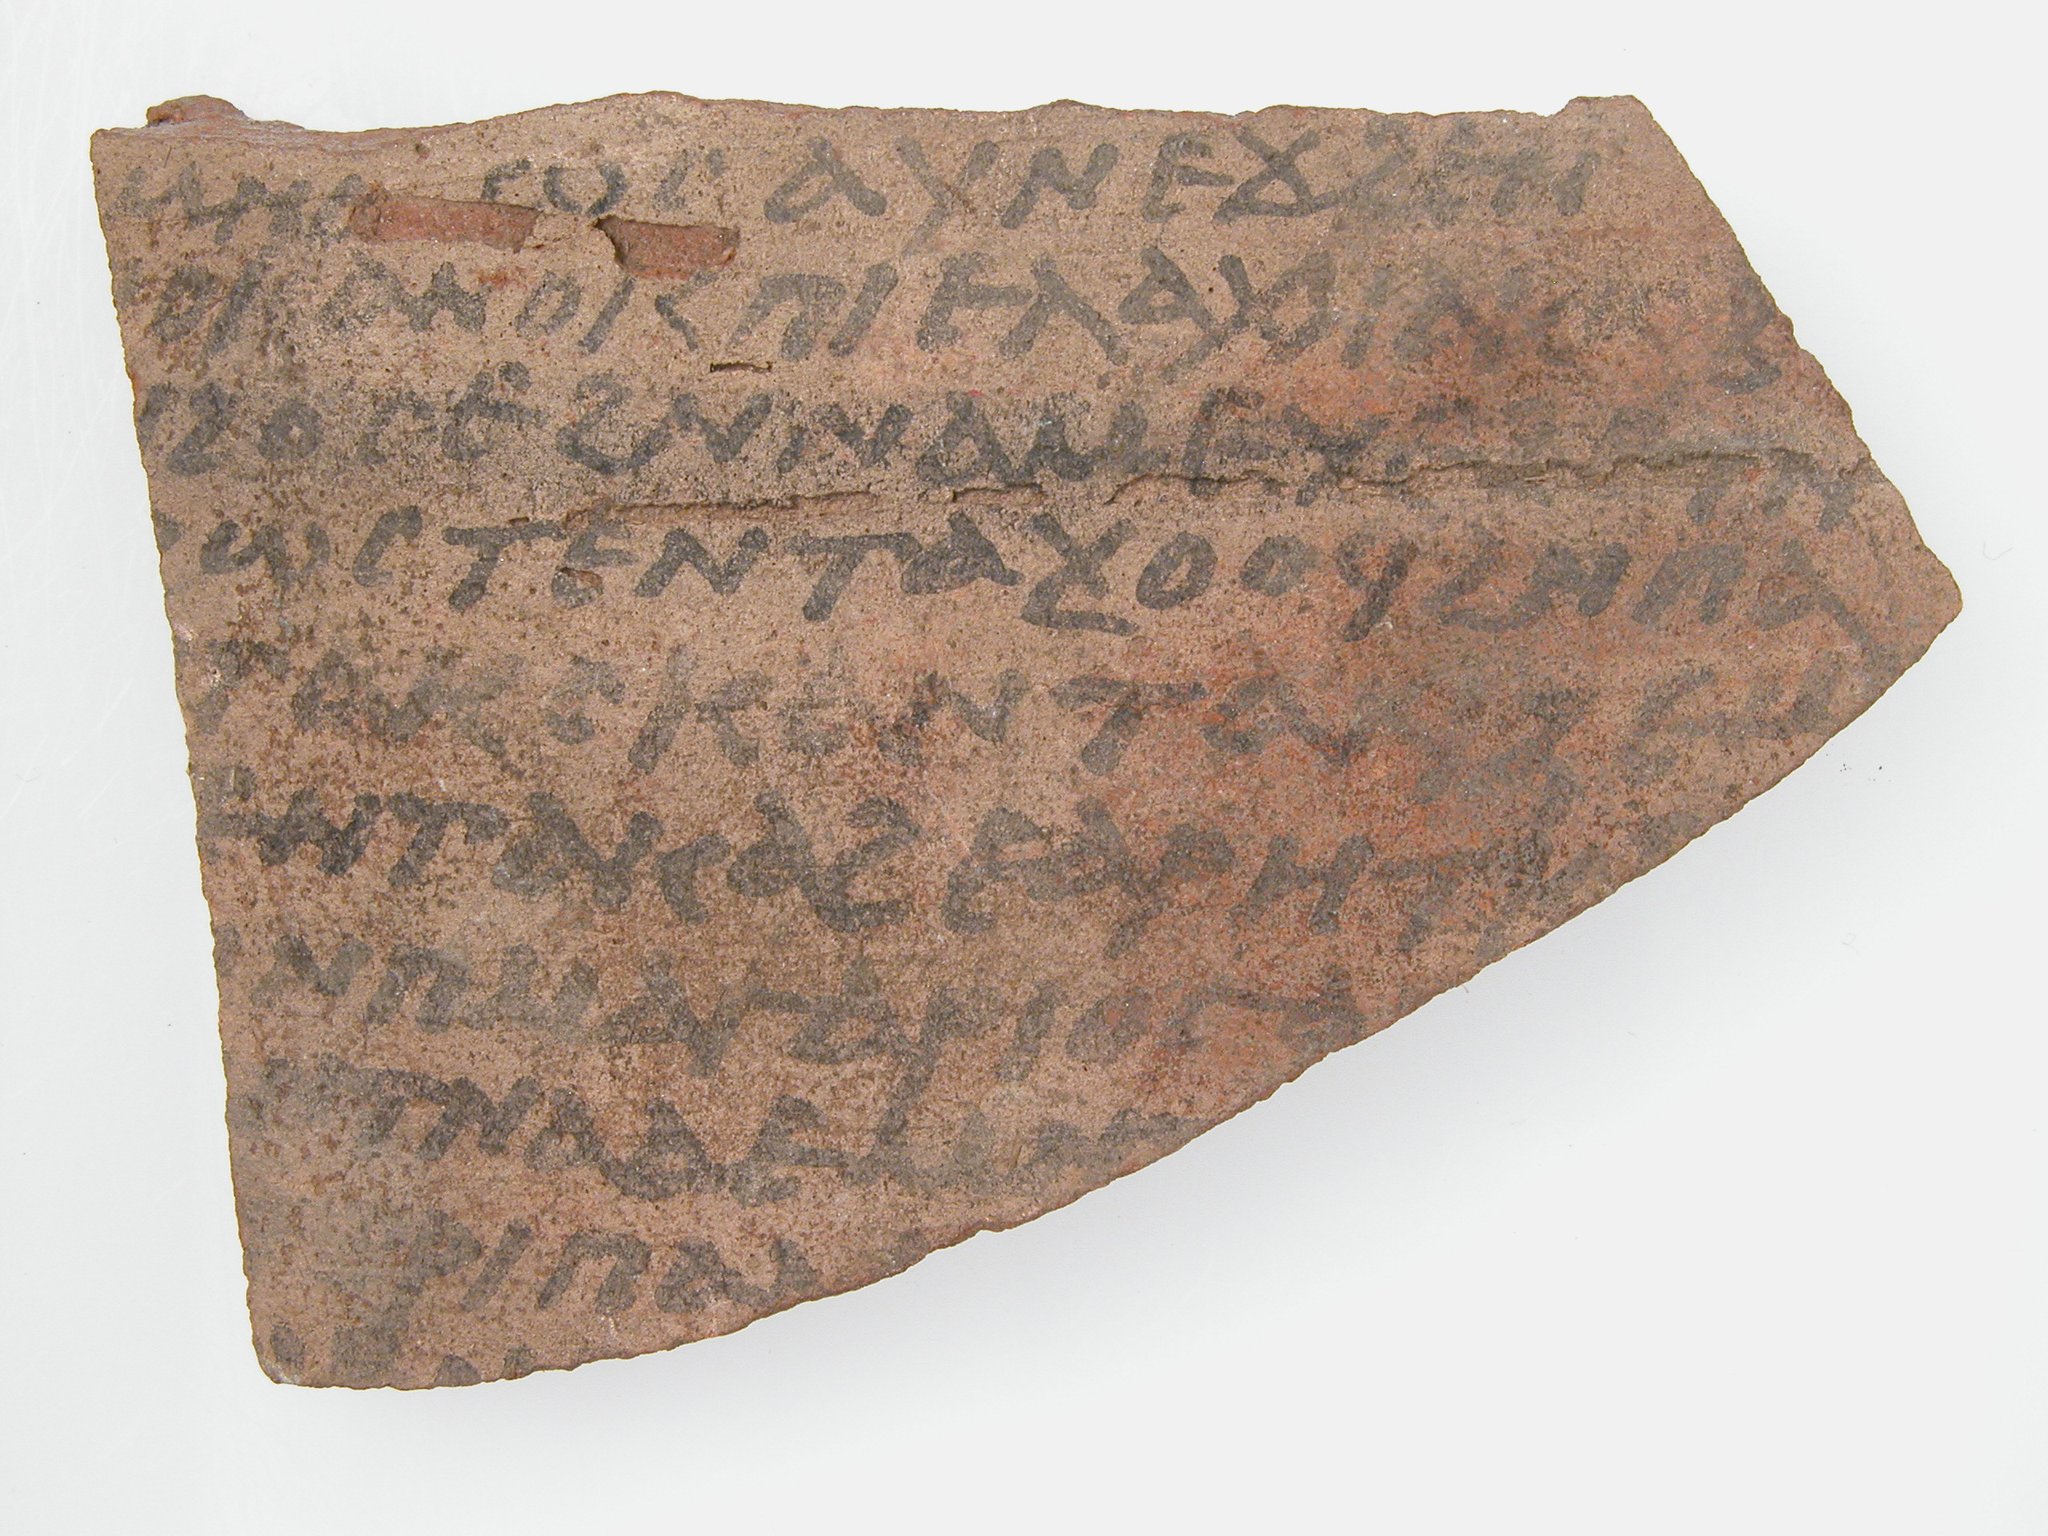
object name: ostrakon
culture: coptic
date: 601-700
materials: ink, pottery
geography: egypt